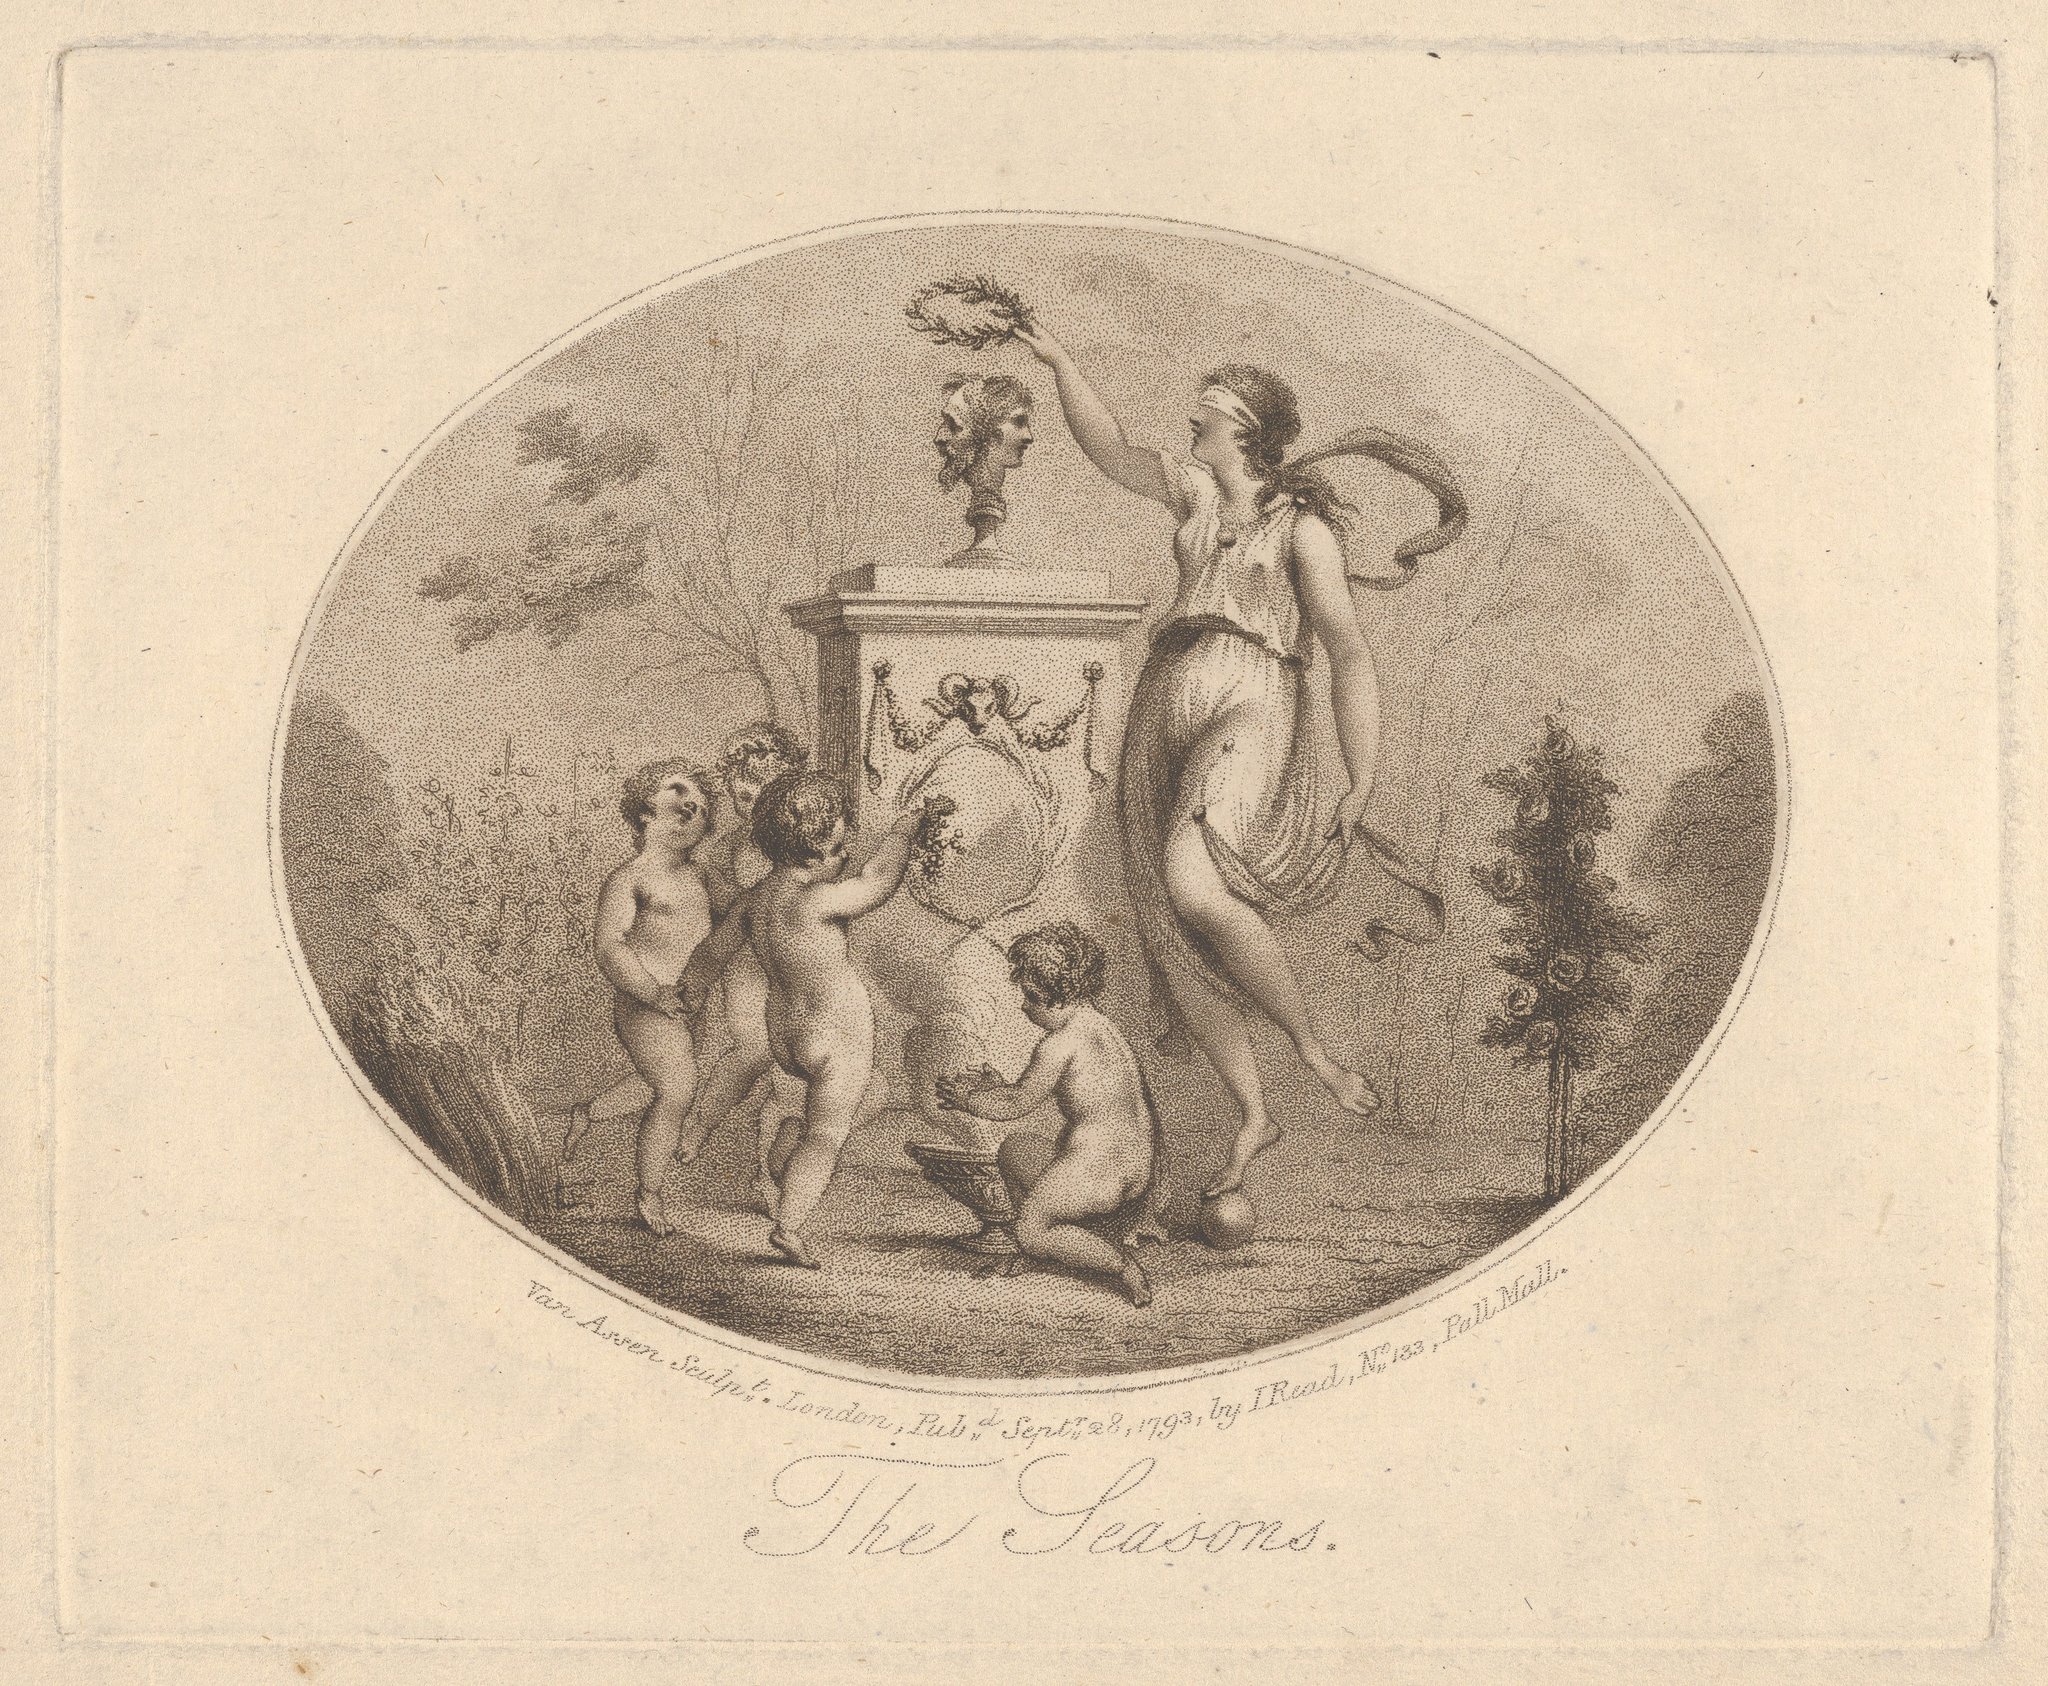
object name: print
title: The Seasons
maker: benedictus antonio van assen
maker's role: engraver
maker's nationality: british, born the netherlands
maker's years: 1767-1817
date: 1793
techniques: engraving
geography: england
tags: nymphs,putti